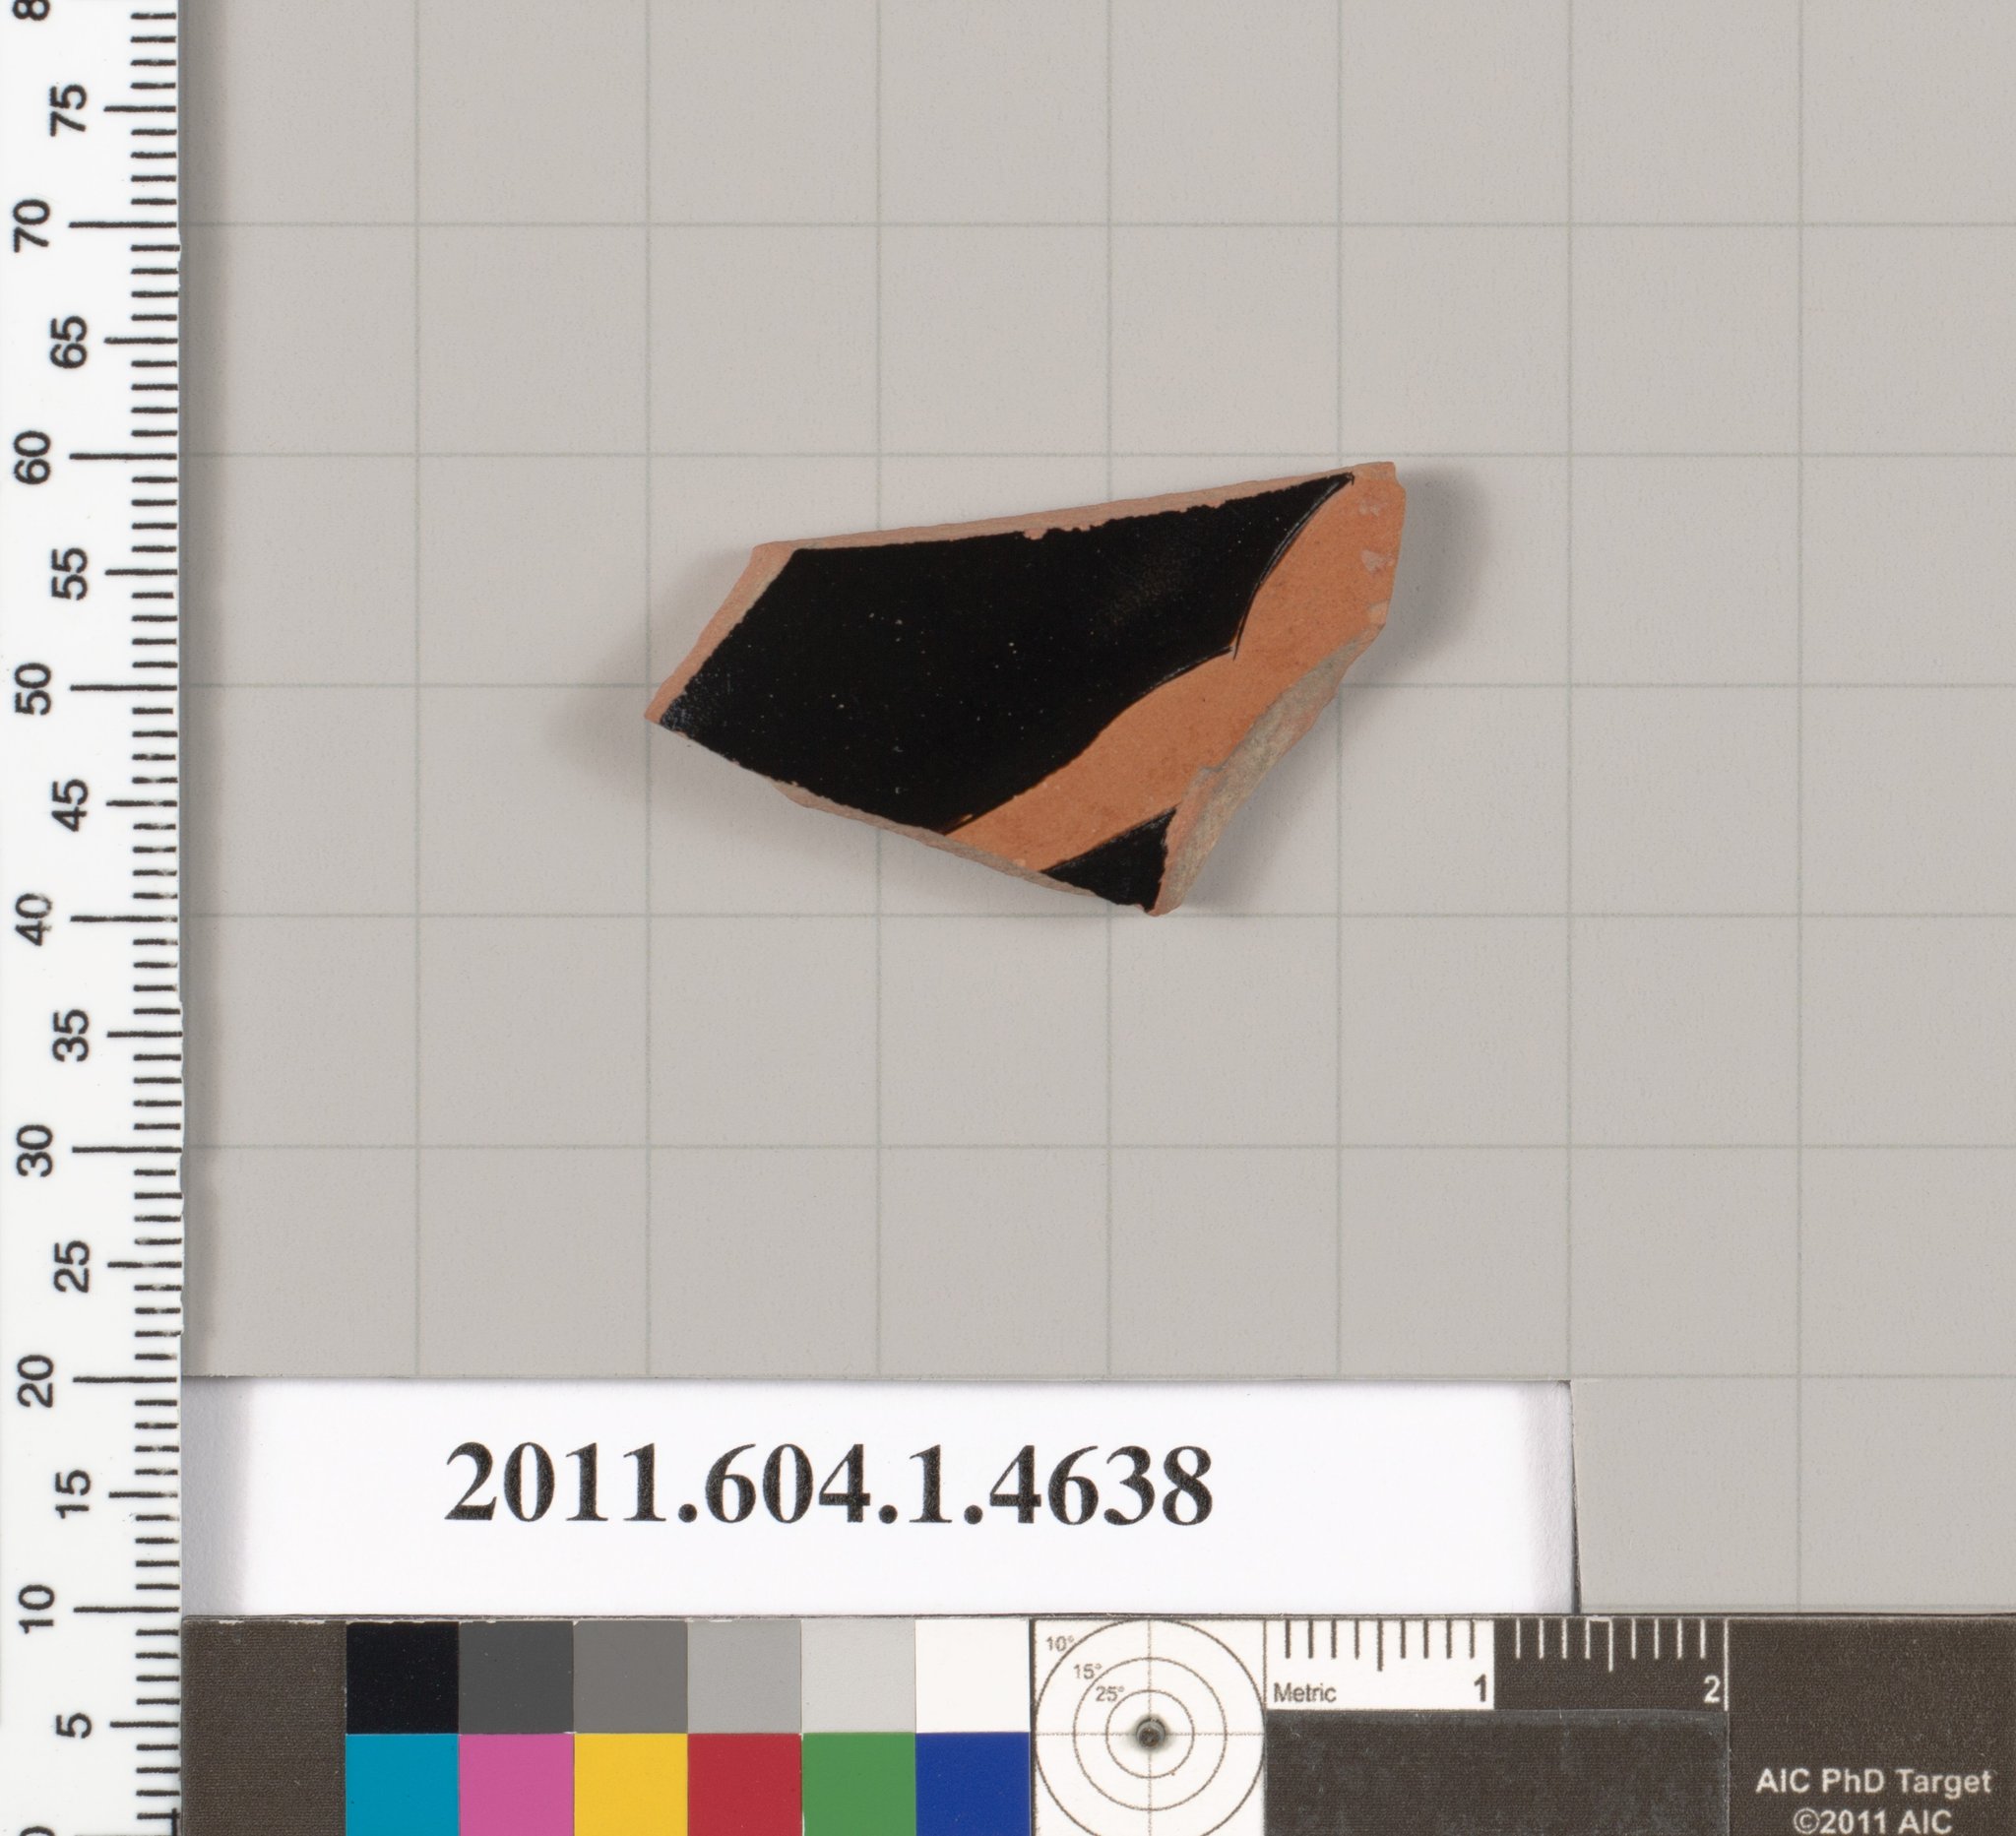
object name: kylix fragment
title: Terracotta fragment of a kylix (drinking cup)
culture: greek, attic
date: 490-480 BCE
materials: terracotta